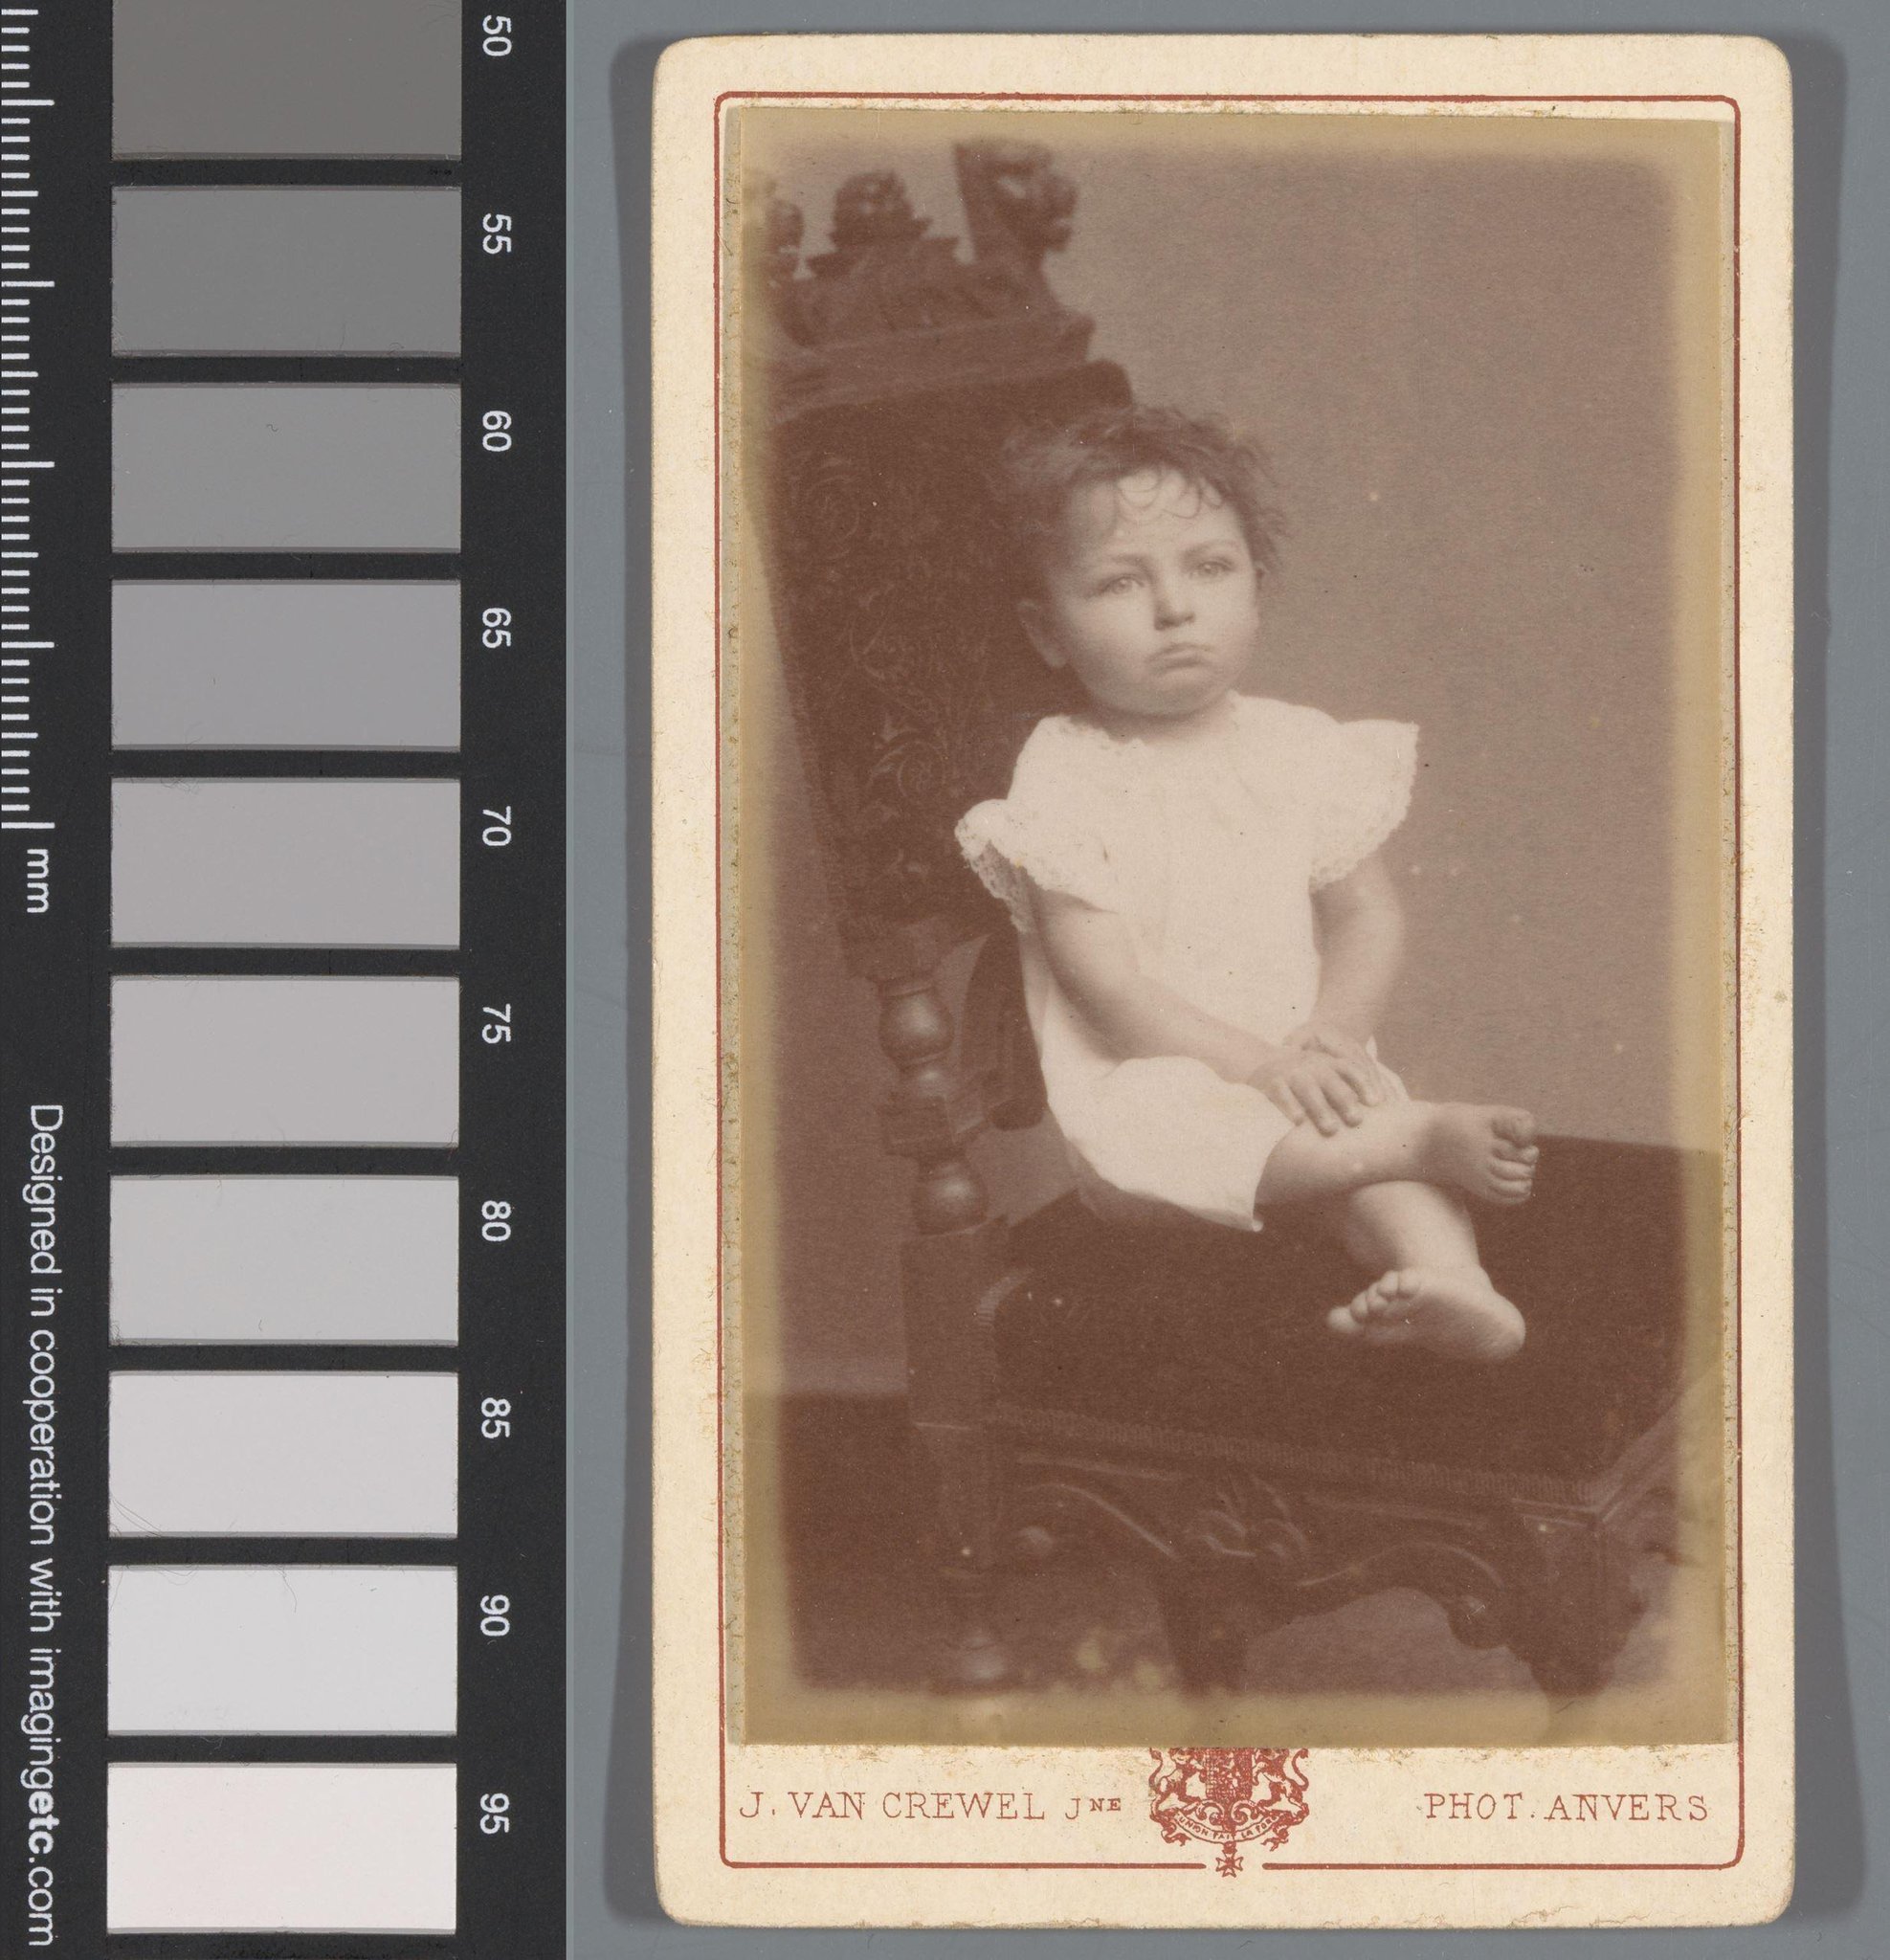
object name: carte de visite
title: Portret van een onbekend kind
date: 1885-1900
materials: cardboard, celluloid, paper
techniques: albumen print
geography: antwerp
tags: child, anonymous historical person portrayed, antwerp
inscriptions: inscription: ‘Brévet d'Invention/ Médaille d'argent a/ l'Exposition Rubens 1881/ obtenue/ pour le procédé instantané./ Maison/ J. van Crewel Jeune/ Photographe (bréveté)/ 48. rue du Pélican, 48/ en face de la Gare/ Anvers/ Tous les Clichés sont conservés’, inscription: ‘J. van Crewel Jne Phot. Anvers’